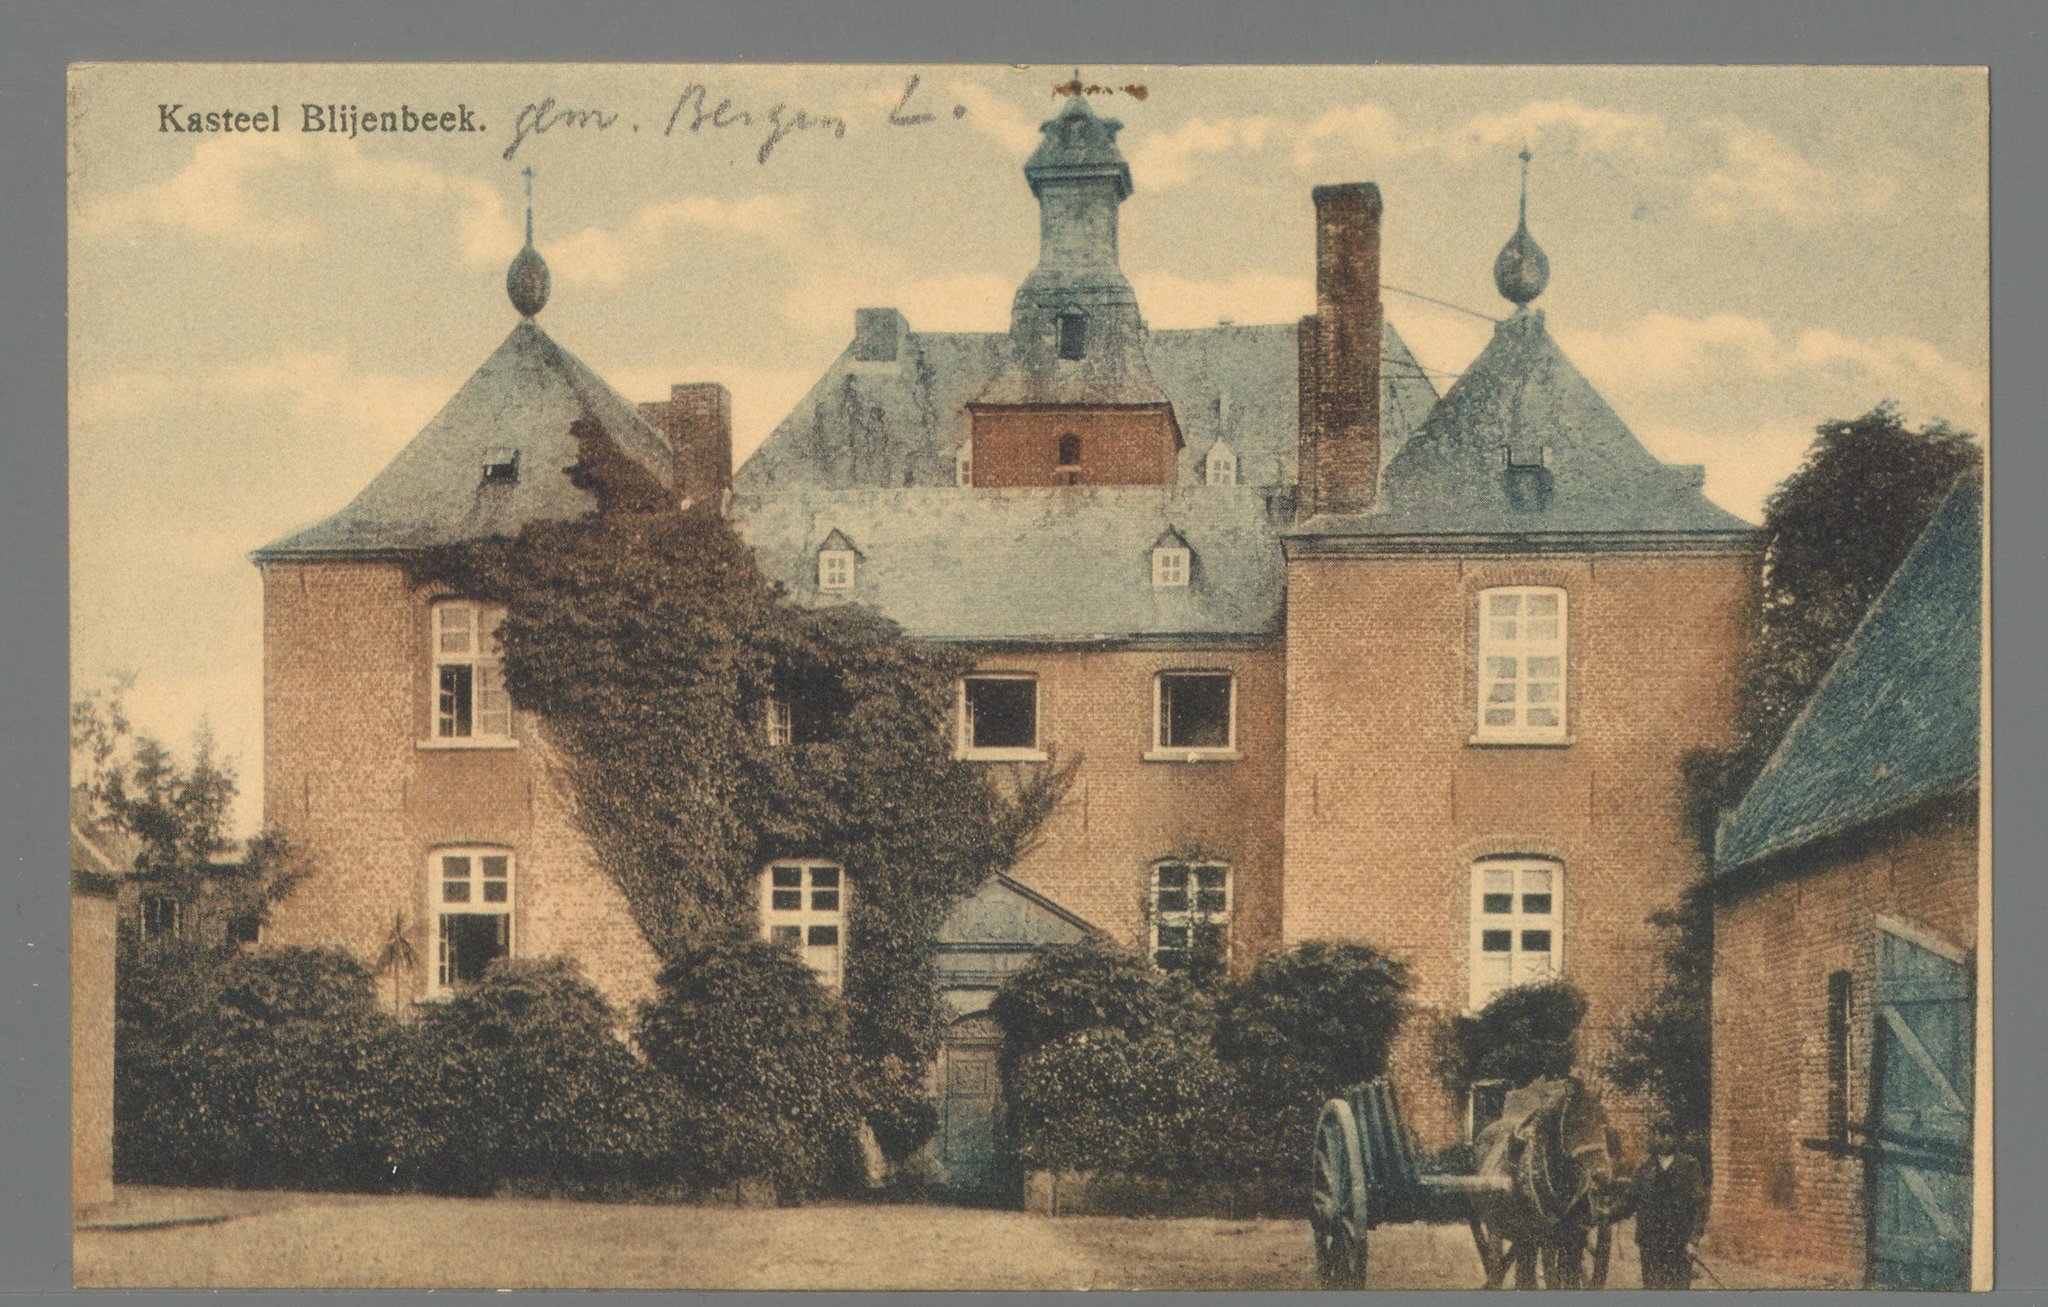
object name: ansichtkaart, prentbriefkaart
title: Kasteel Blijenbeek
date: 1905-1930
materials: cardboard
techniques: collotype process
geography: amsterdam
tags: castle